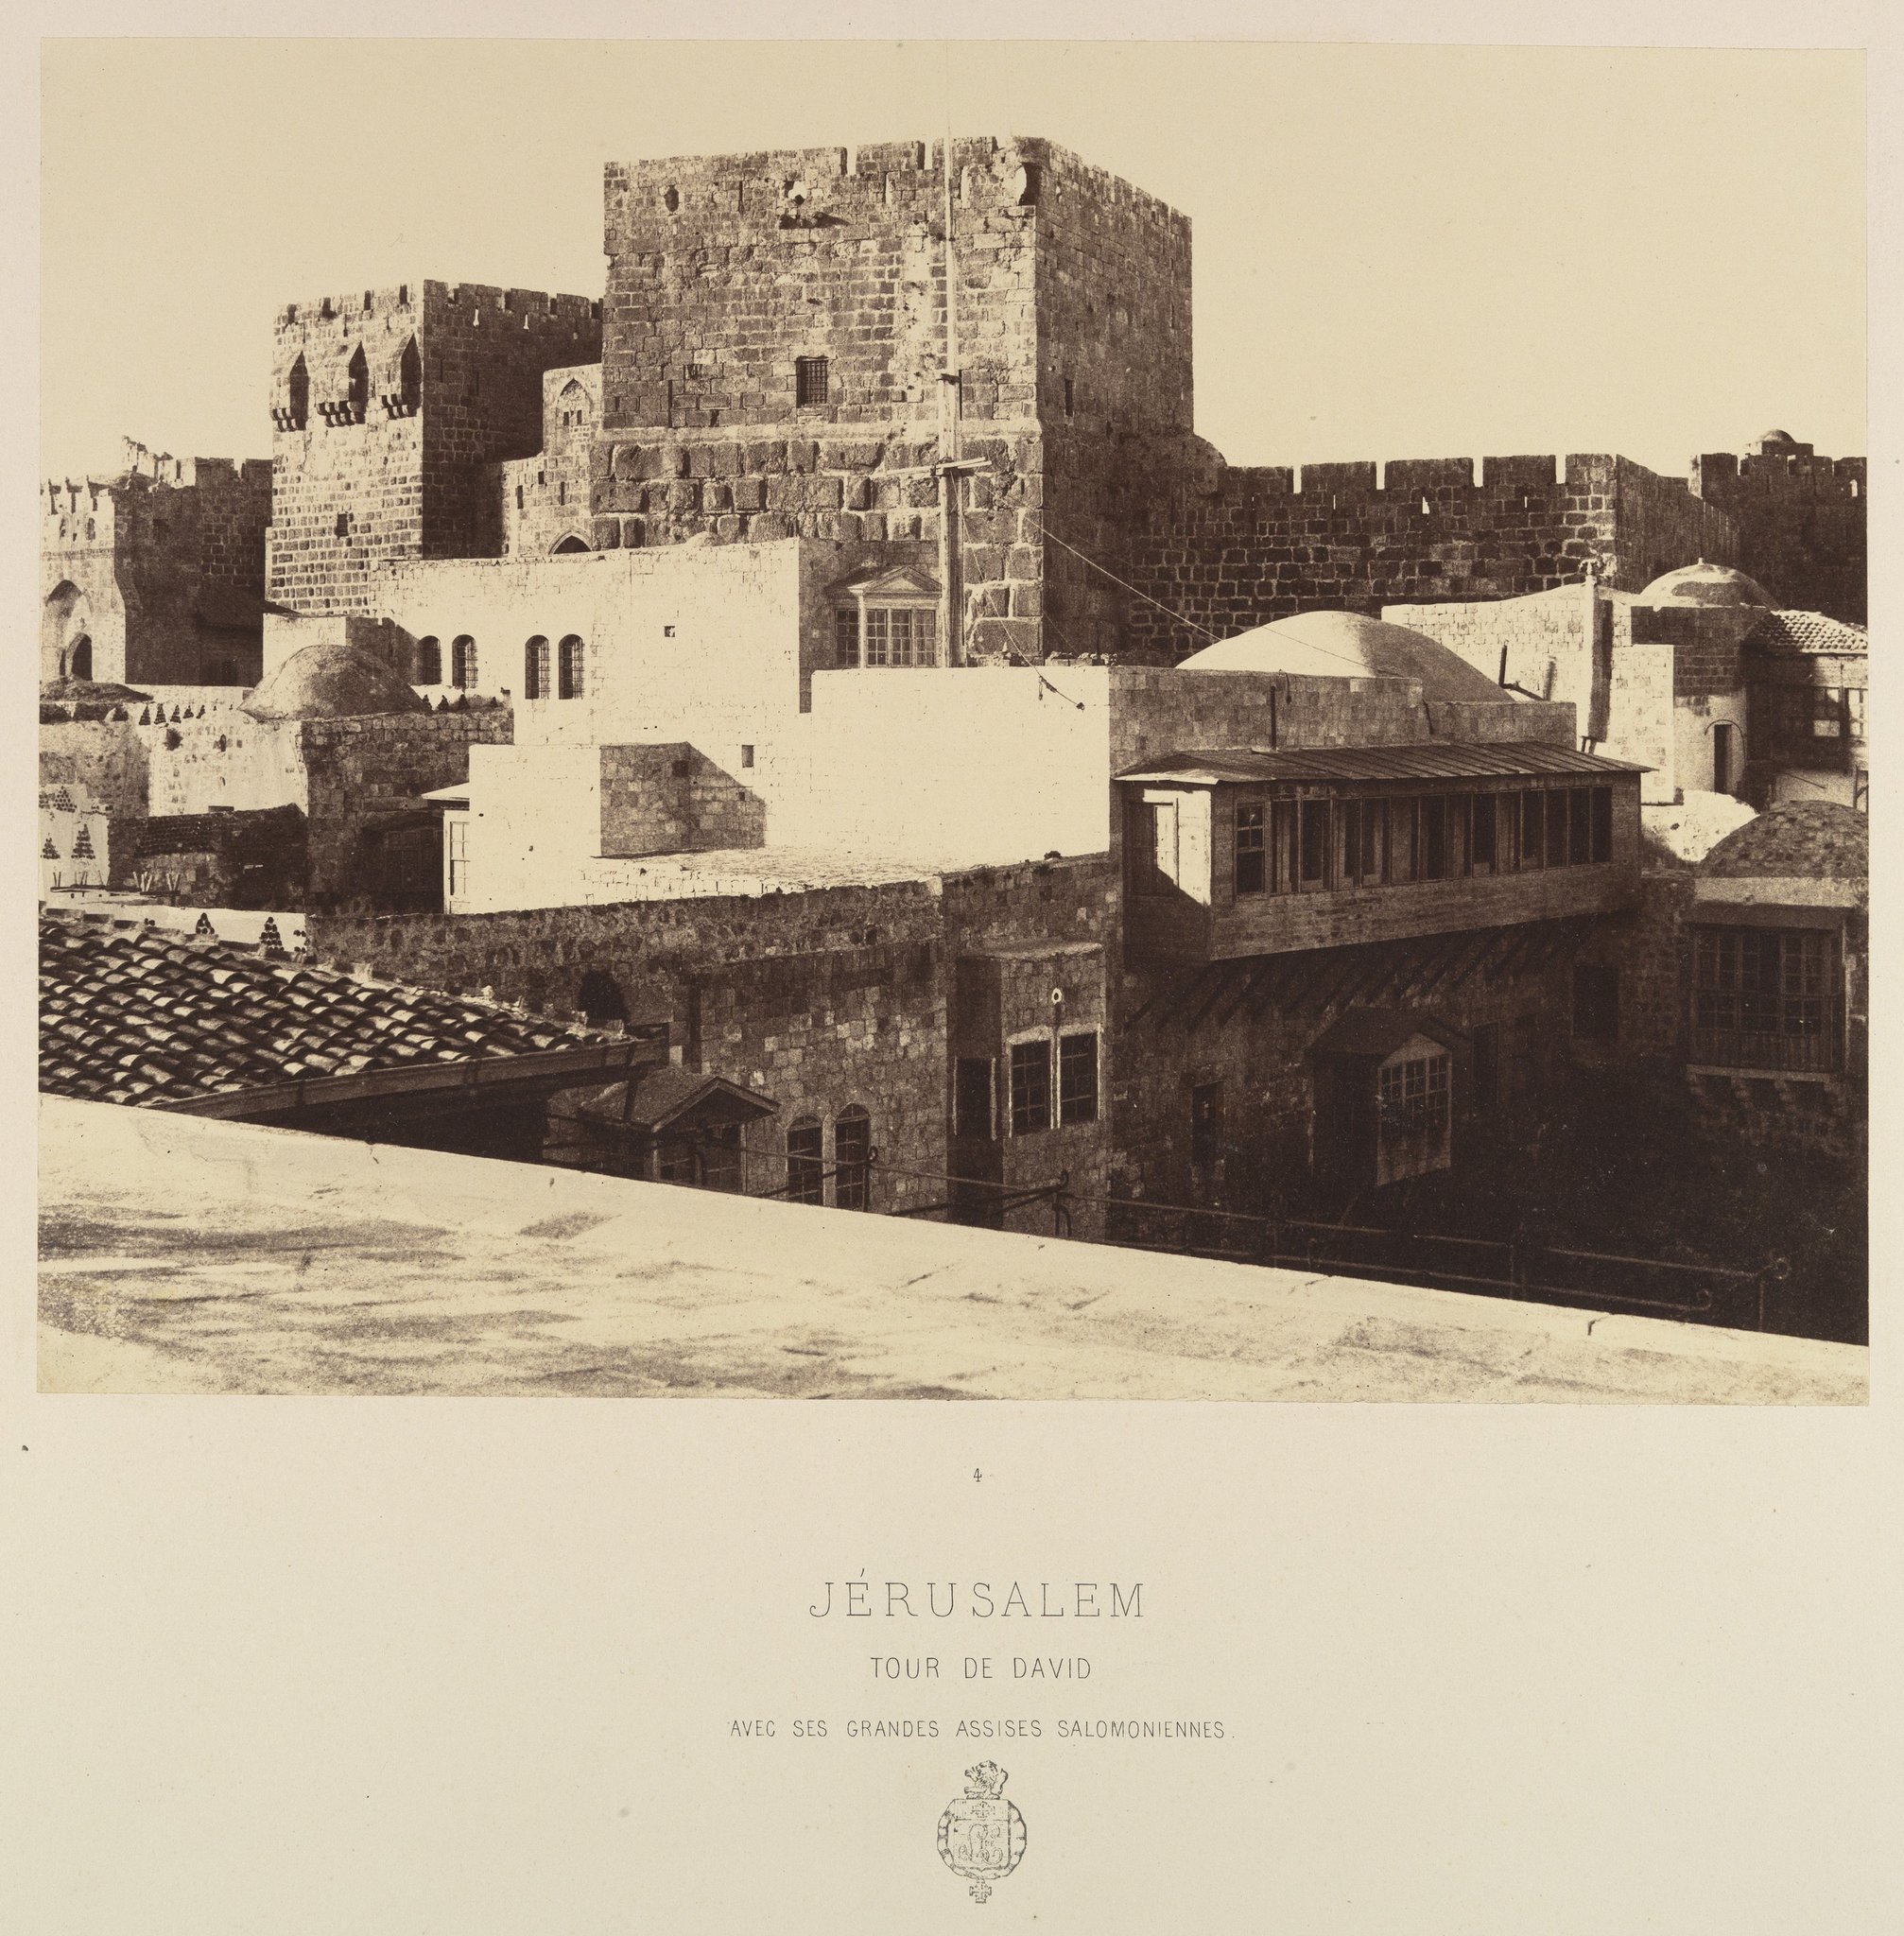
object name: photograph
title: Jérusalem. Tour de David avec ses grandes assises salomoniennes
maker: louis de clercq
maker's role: artist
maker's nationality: french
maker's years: 1837-1901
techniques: albumen silver print, paper negative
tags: buildings